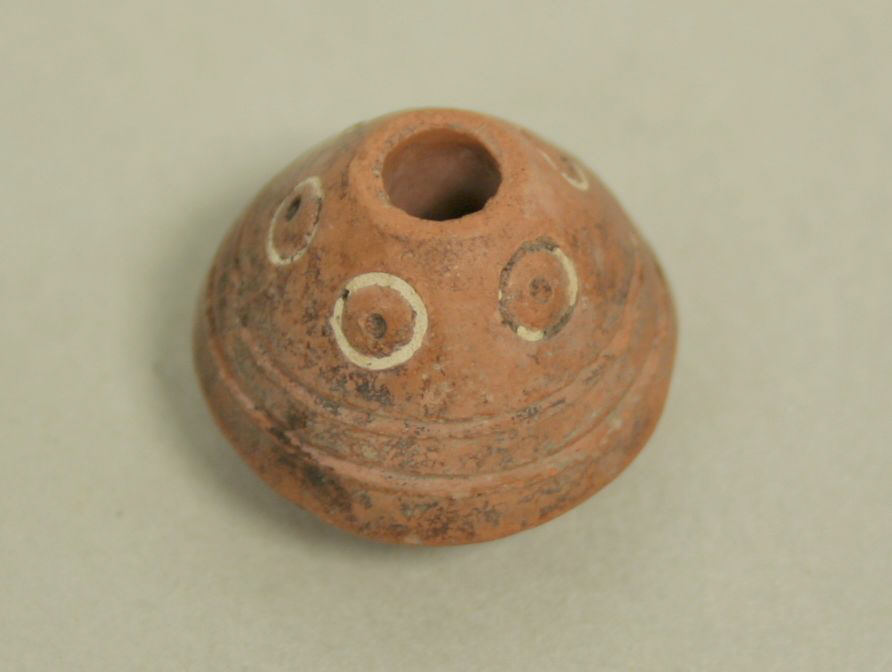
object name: spindle whorl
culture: peruvian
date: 1-500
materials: ceramic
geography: peru